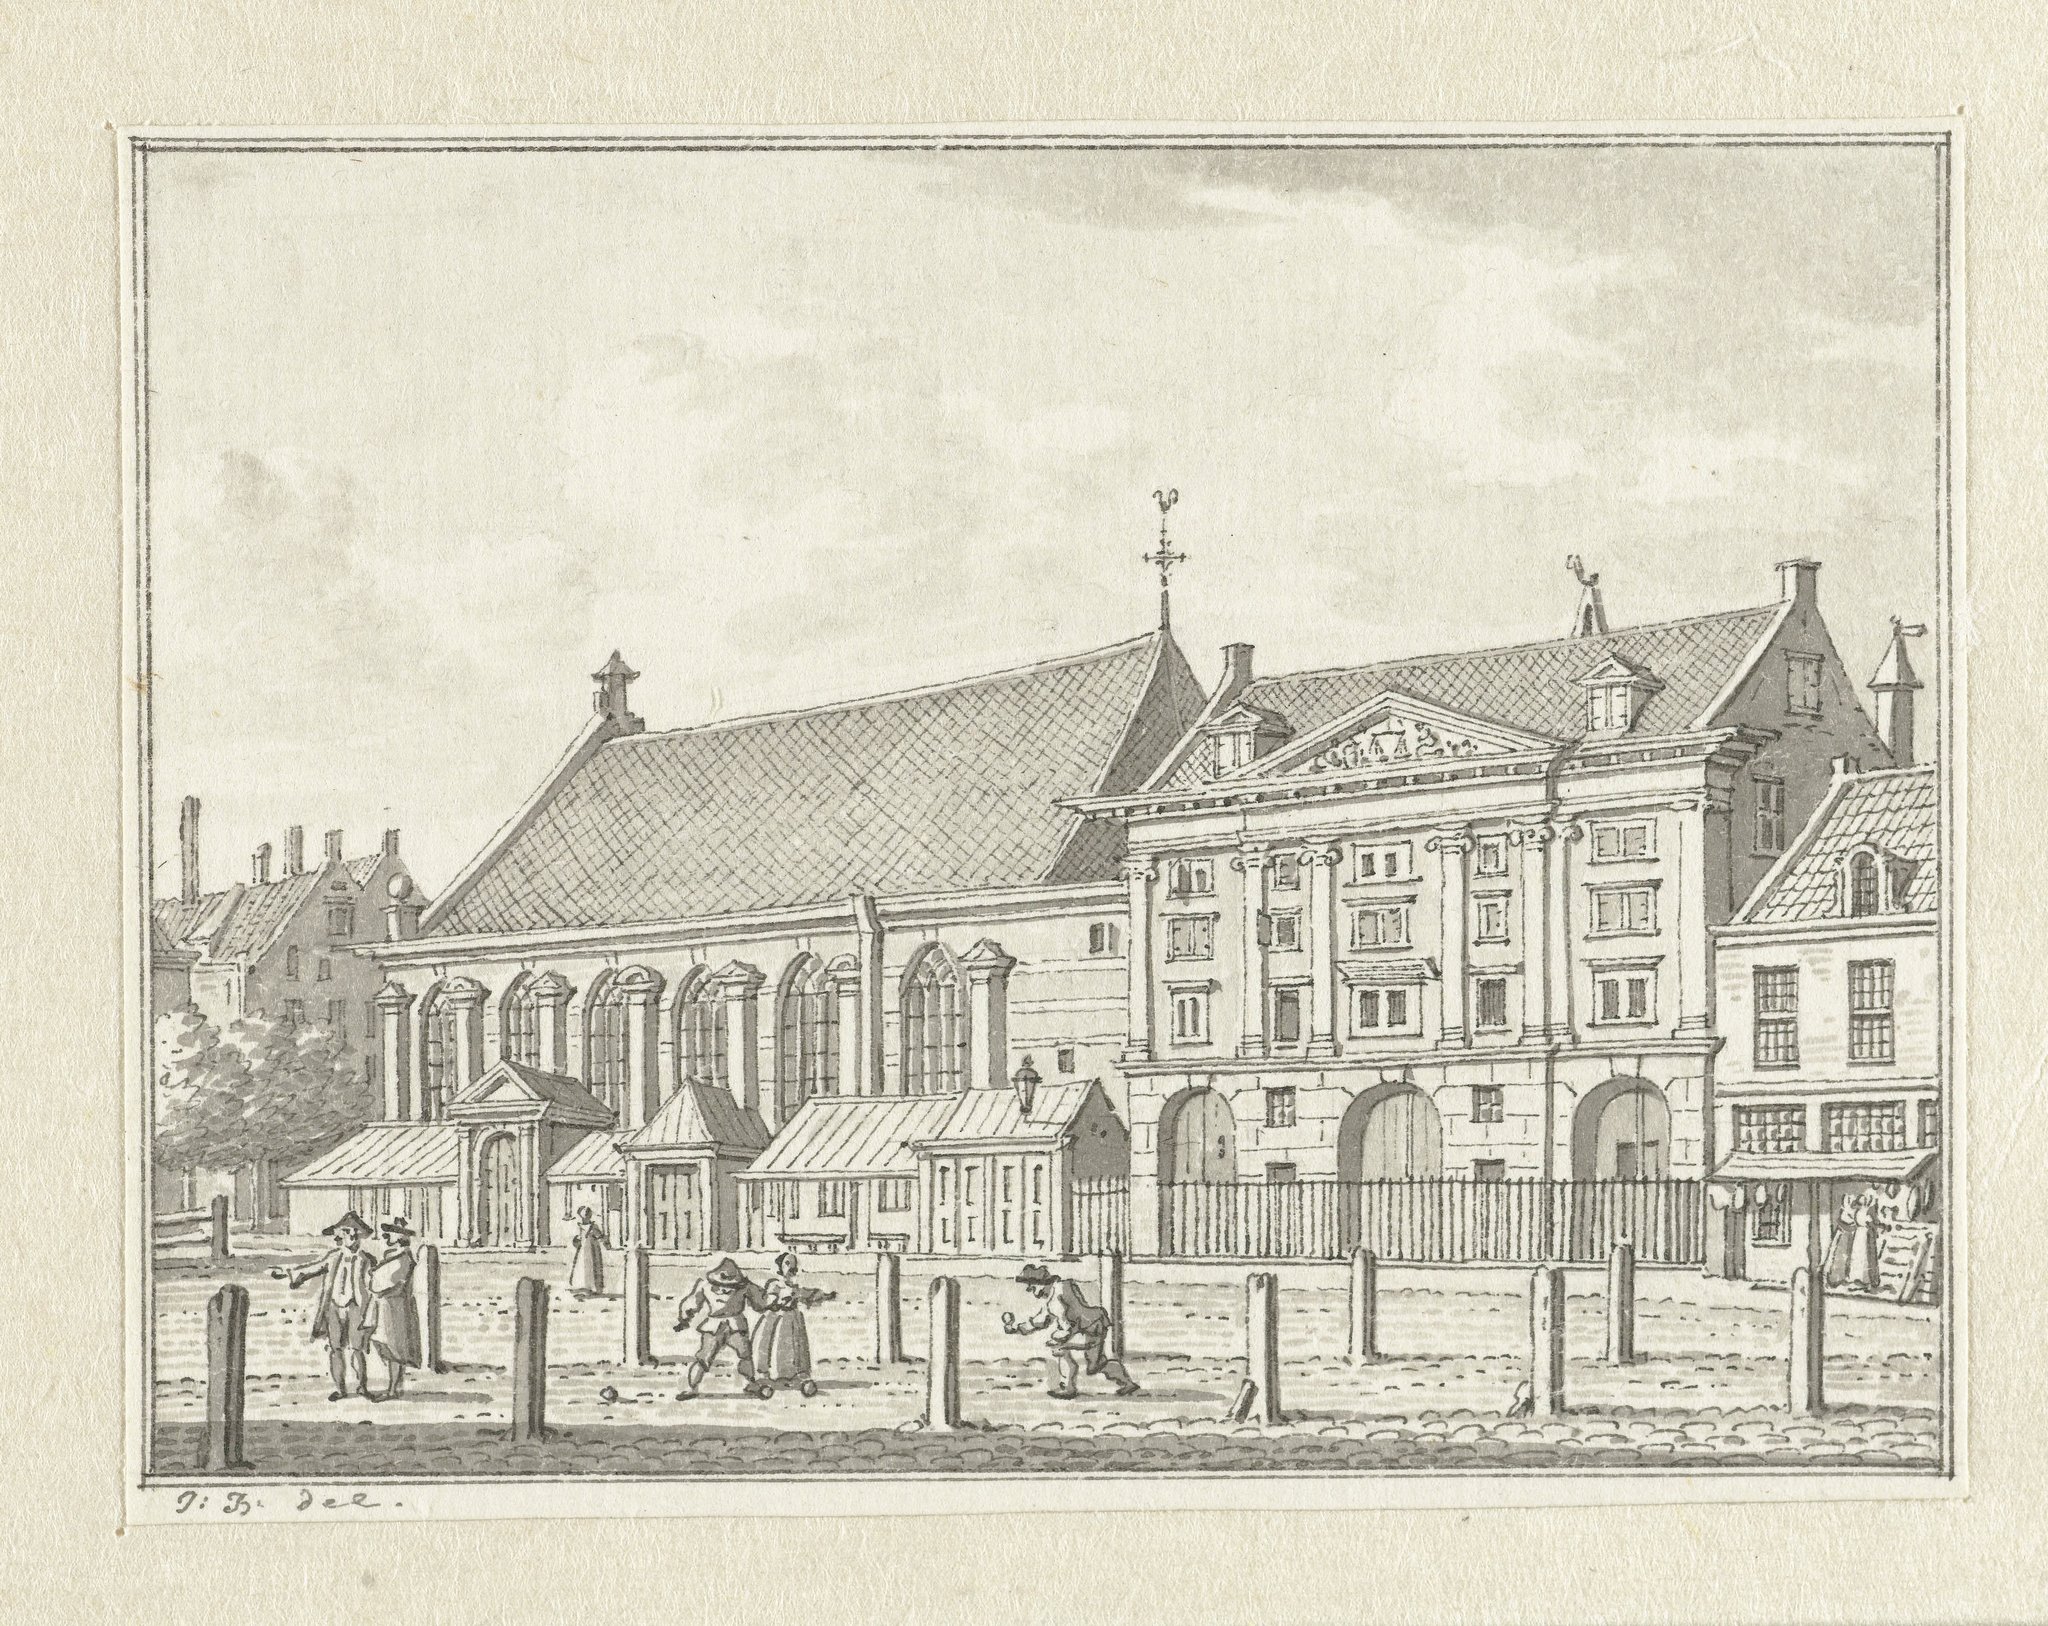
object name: drawing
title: De Prinsekerk en Boterhal te Rotterdam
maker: jan bulthuis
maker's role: draughtsman, print maker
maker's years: 1750-1801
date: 1790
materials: ink, paper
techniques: brush, pen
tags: church (exterior), rotterdam